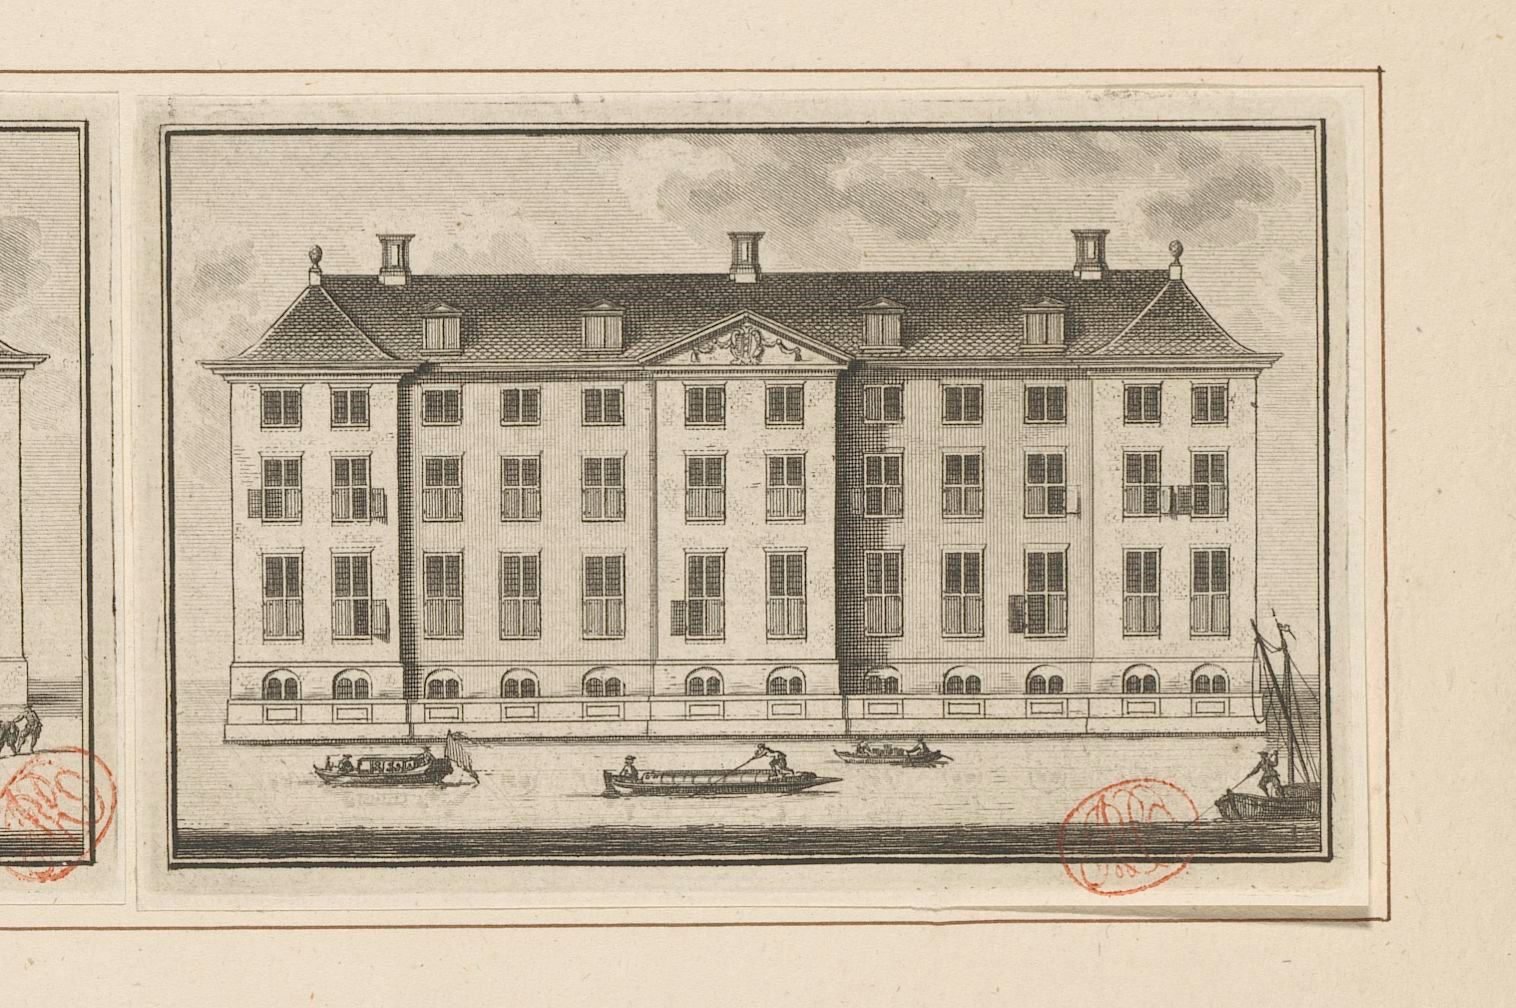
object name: print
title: Gezicht op de achterzijde van het Diaconieweeshuis te Amsterdam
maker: Anonymous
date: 1675-1725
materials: paper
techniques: engraving, etching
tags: public welfare, orphanage, canals, waters (in city) (+ city(-scape) with figures, staffage)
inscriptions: collector's mark: Lugt 195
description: Gezicht op de achterkant van het in 1657 in gebruik genomen Diaconieweeshuis op Vlooienburg te Amsterdam, gezien vanaf de Binnen-Amstel. Dit weeshuis lag op de hoek van de Binnen-Amstel en de Zwanenburgerstraat. Bedoeld voor wezen van Nederduits Gereformeerde (later Hervormde) huize wier ouders geen poorters waren.